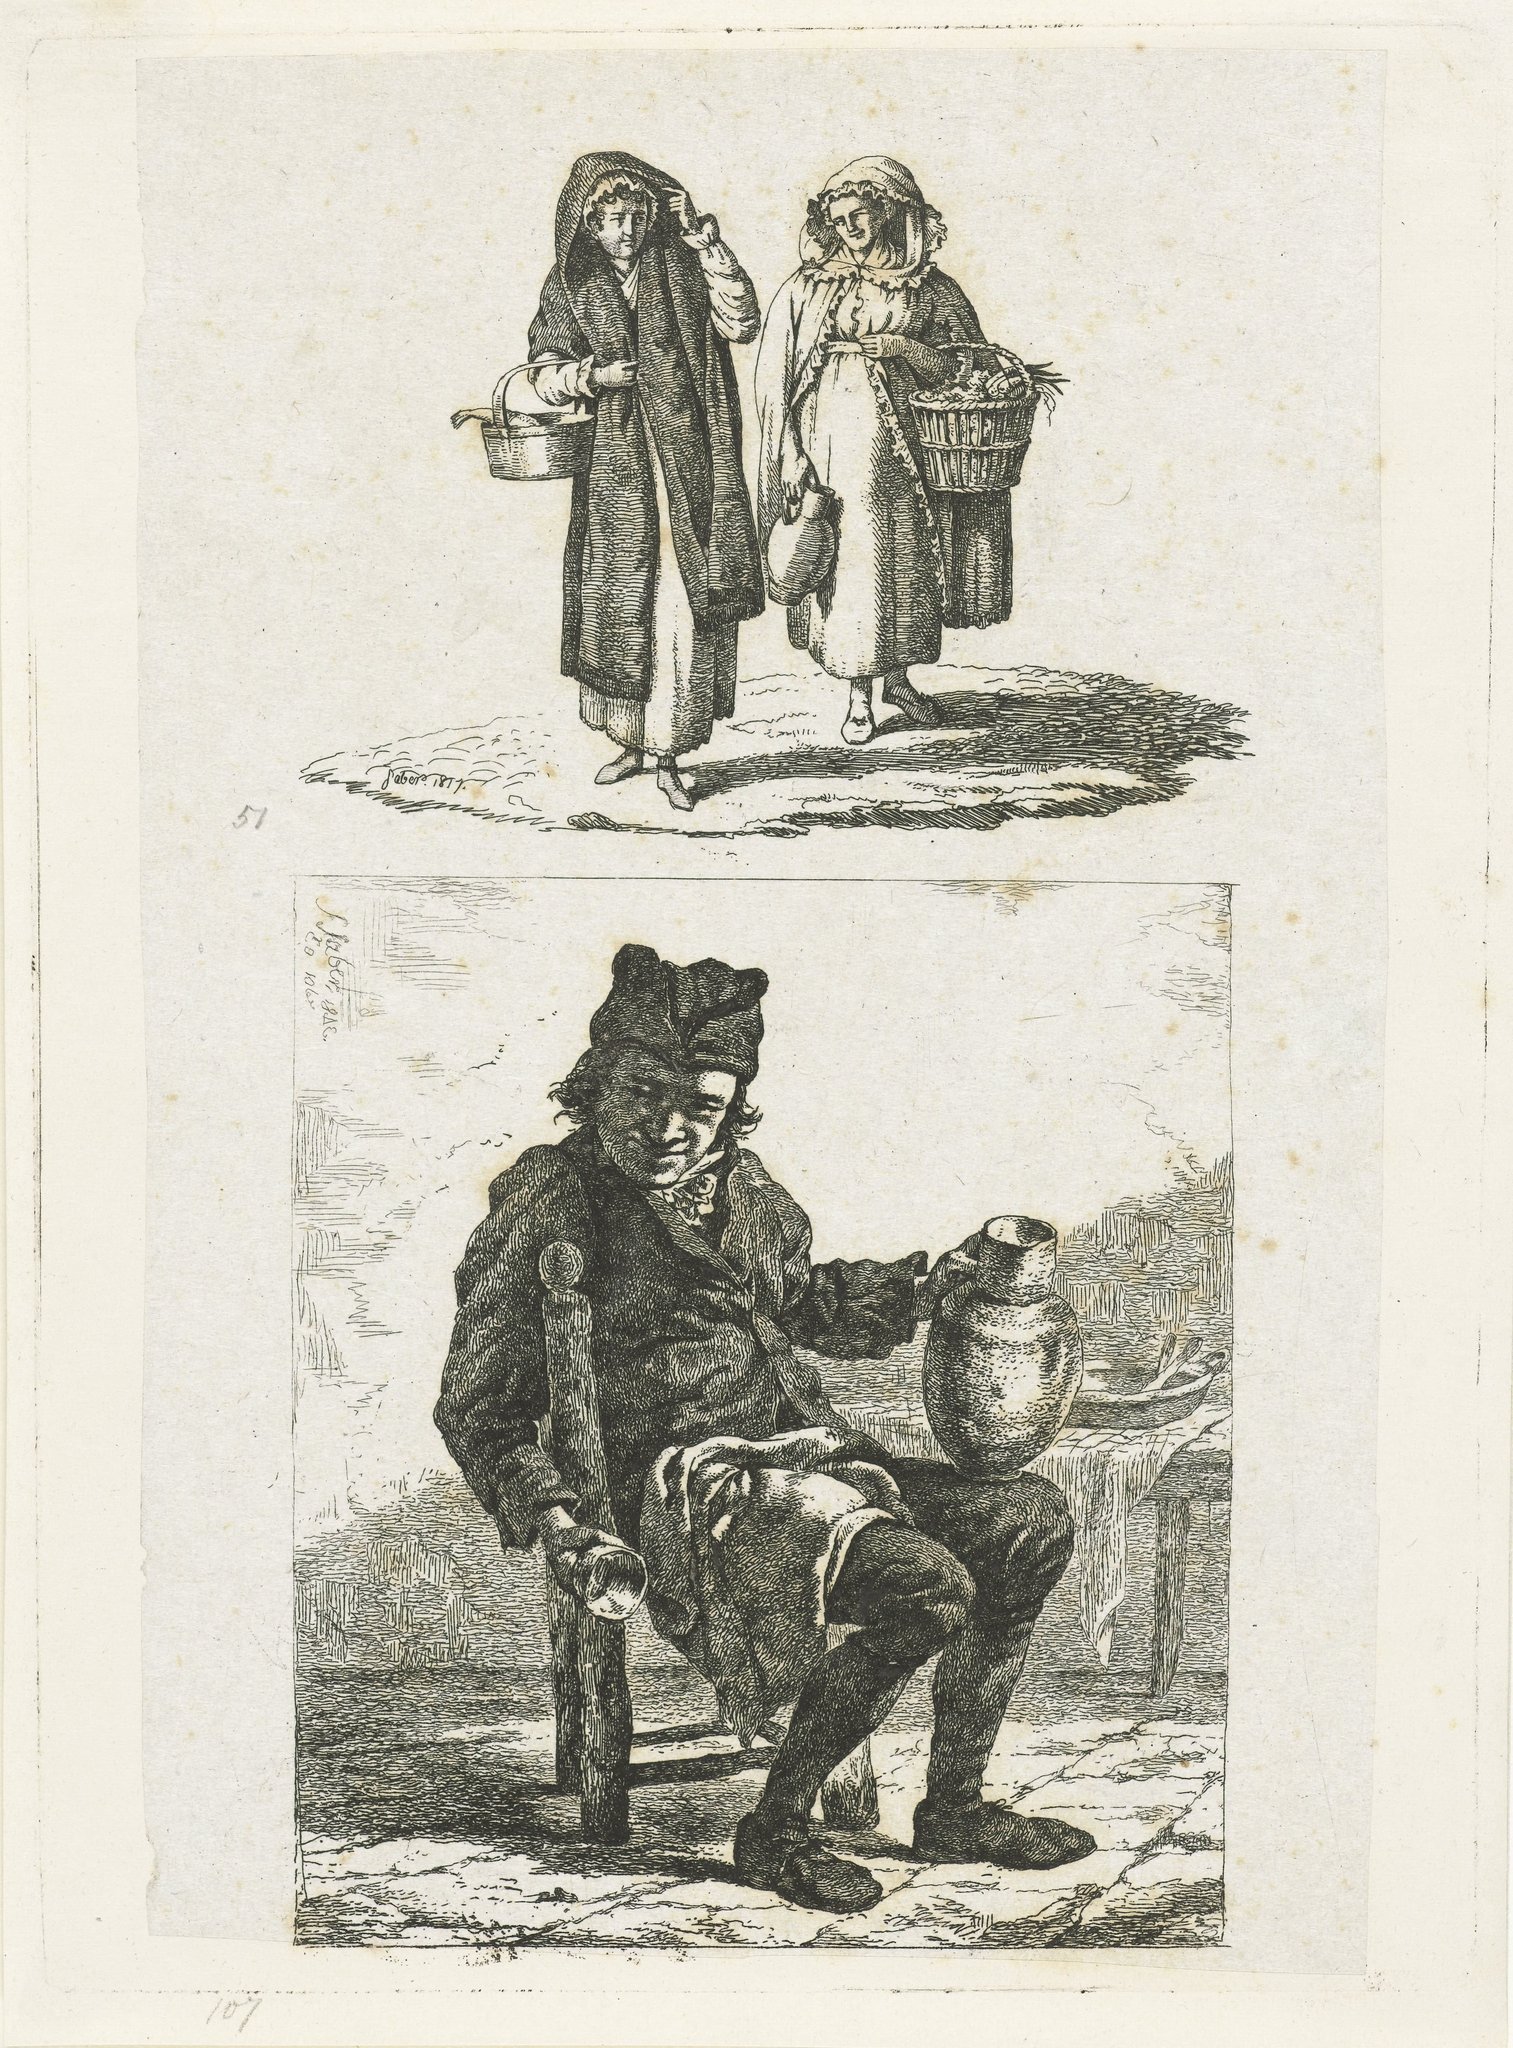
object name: print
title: Twee vrouwen en een zittende man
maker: frédéric théodore faber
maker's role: print maker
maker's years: 1782-1844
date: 1817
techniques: printmaking, etching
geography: brussels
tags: jar, jug (used as drinking-vessel)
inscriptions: collector's mark: Lugt 1485, collector's mark: Lugt 2228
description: Twee voorstellingen op één blad. Boven: twee vrouwen elk met een mand aan de arm. Onder: een zittende man met een kruik in de ene en een beker in de andere hand.